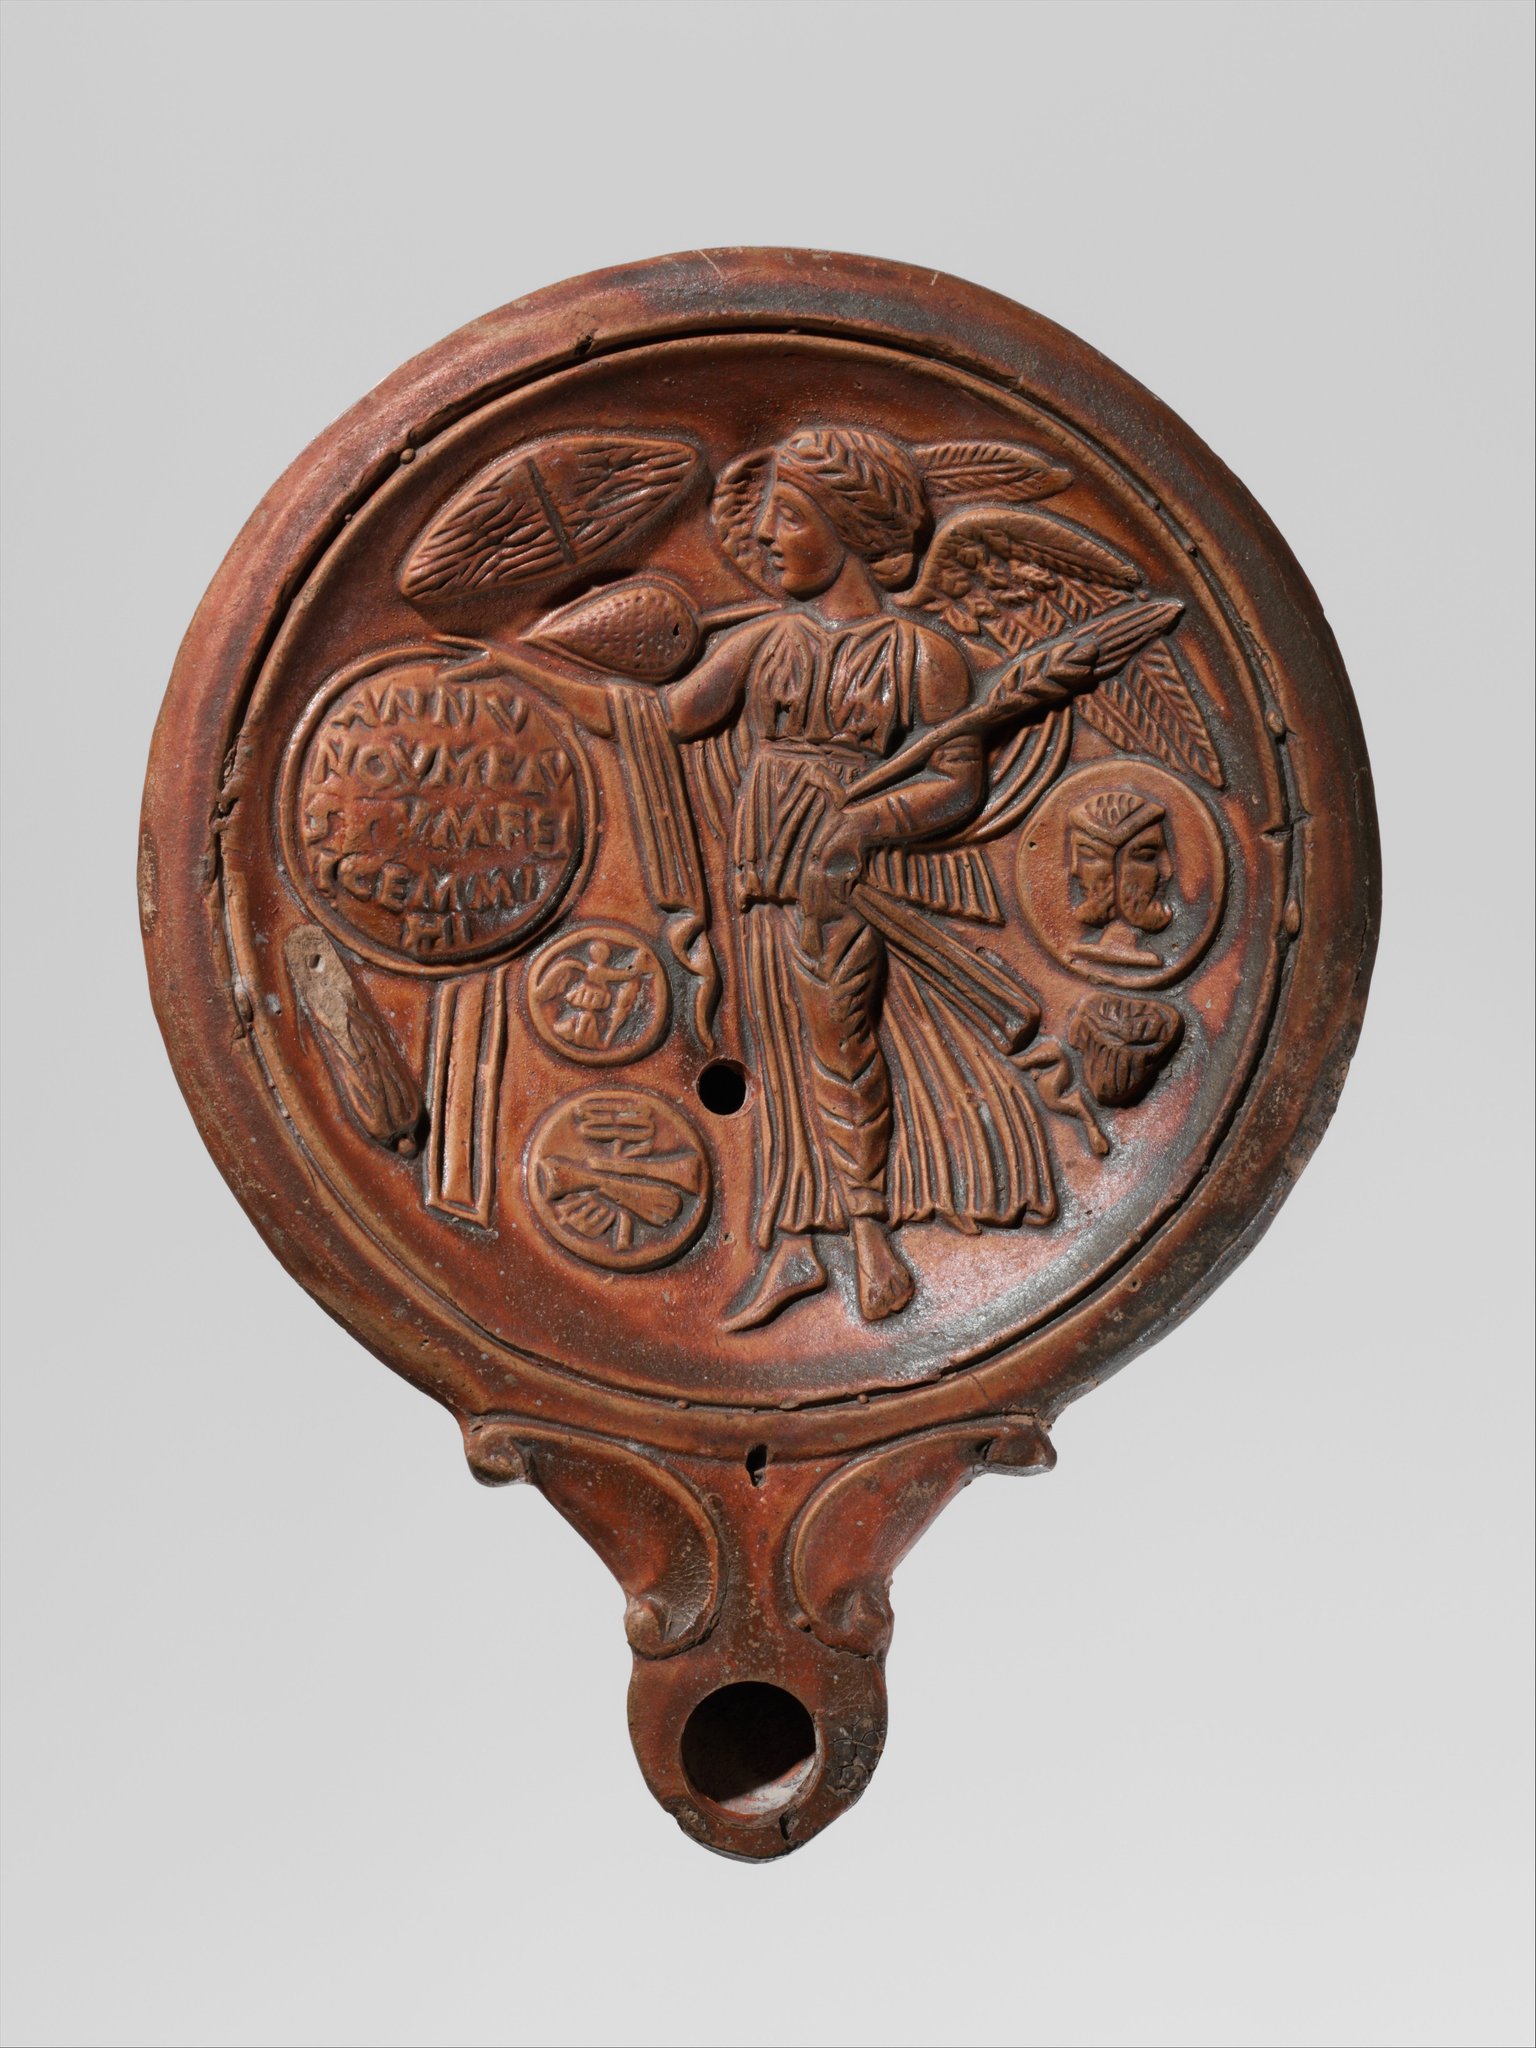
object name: lamp with relief of victory holding a shield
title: Terracotta oil lamp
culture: roman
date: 51-100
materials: terracotta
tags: shields,victory